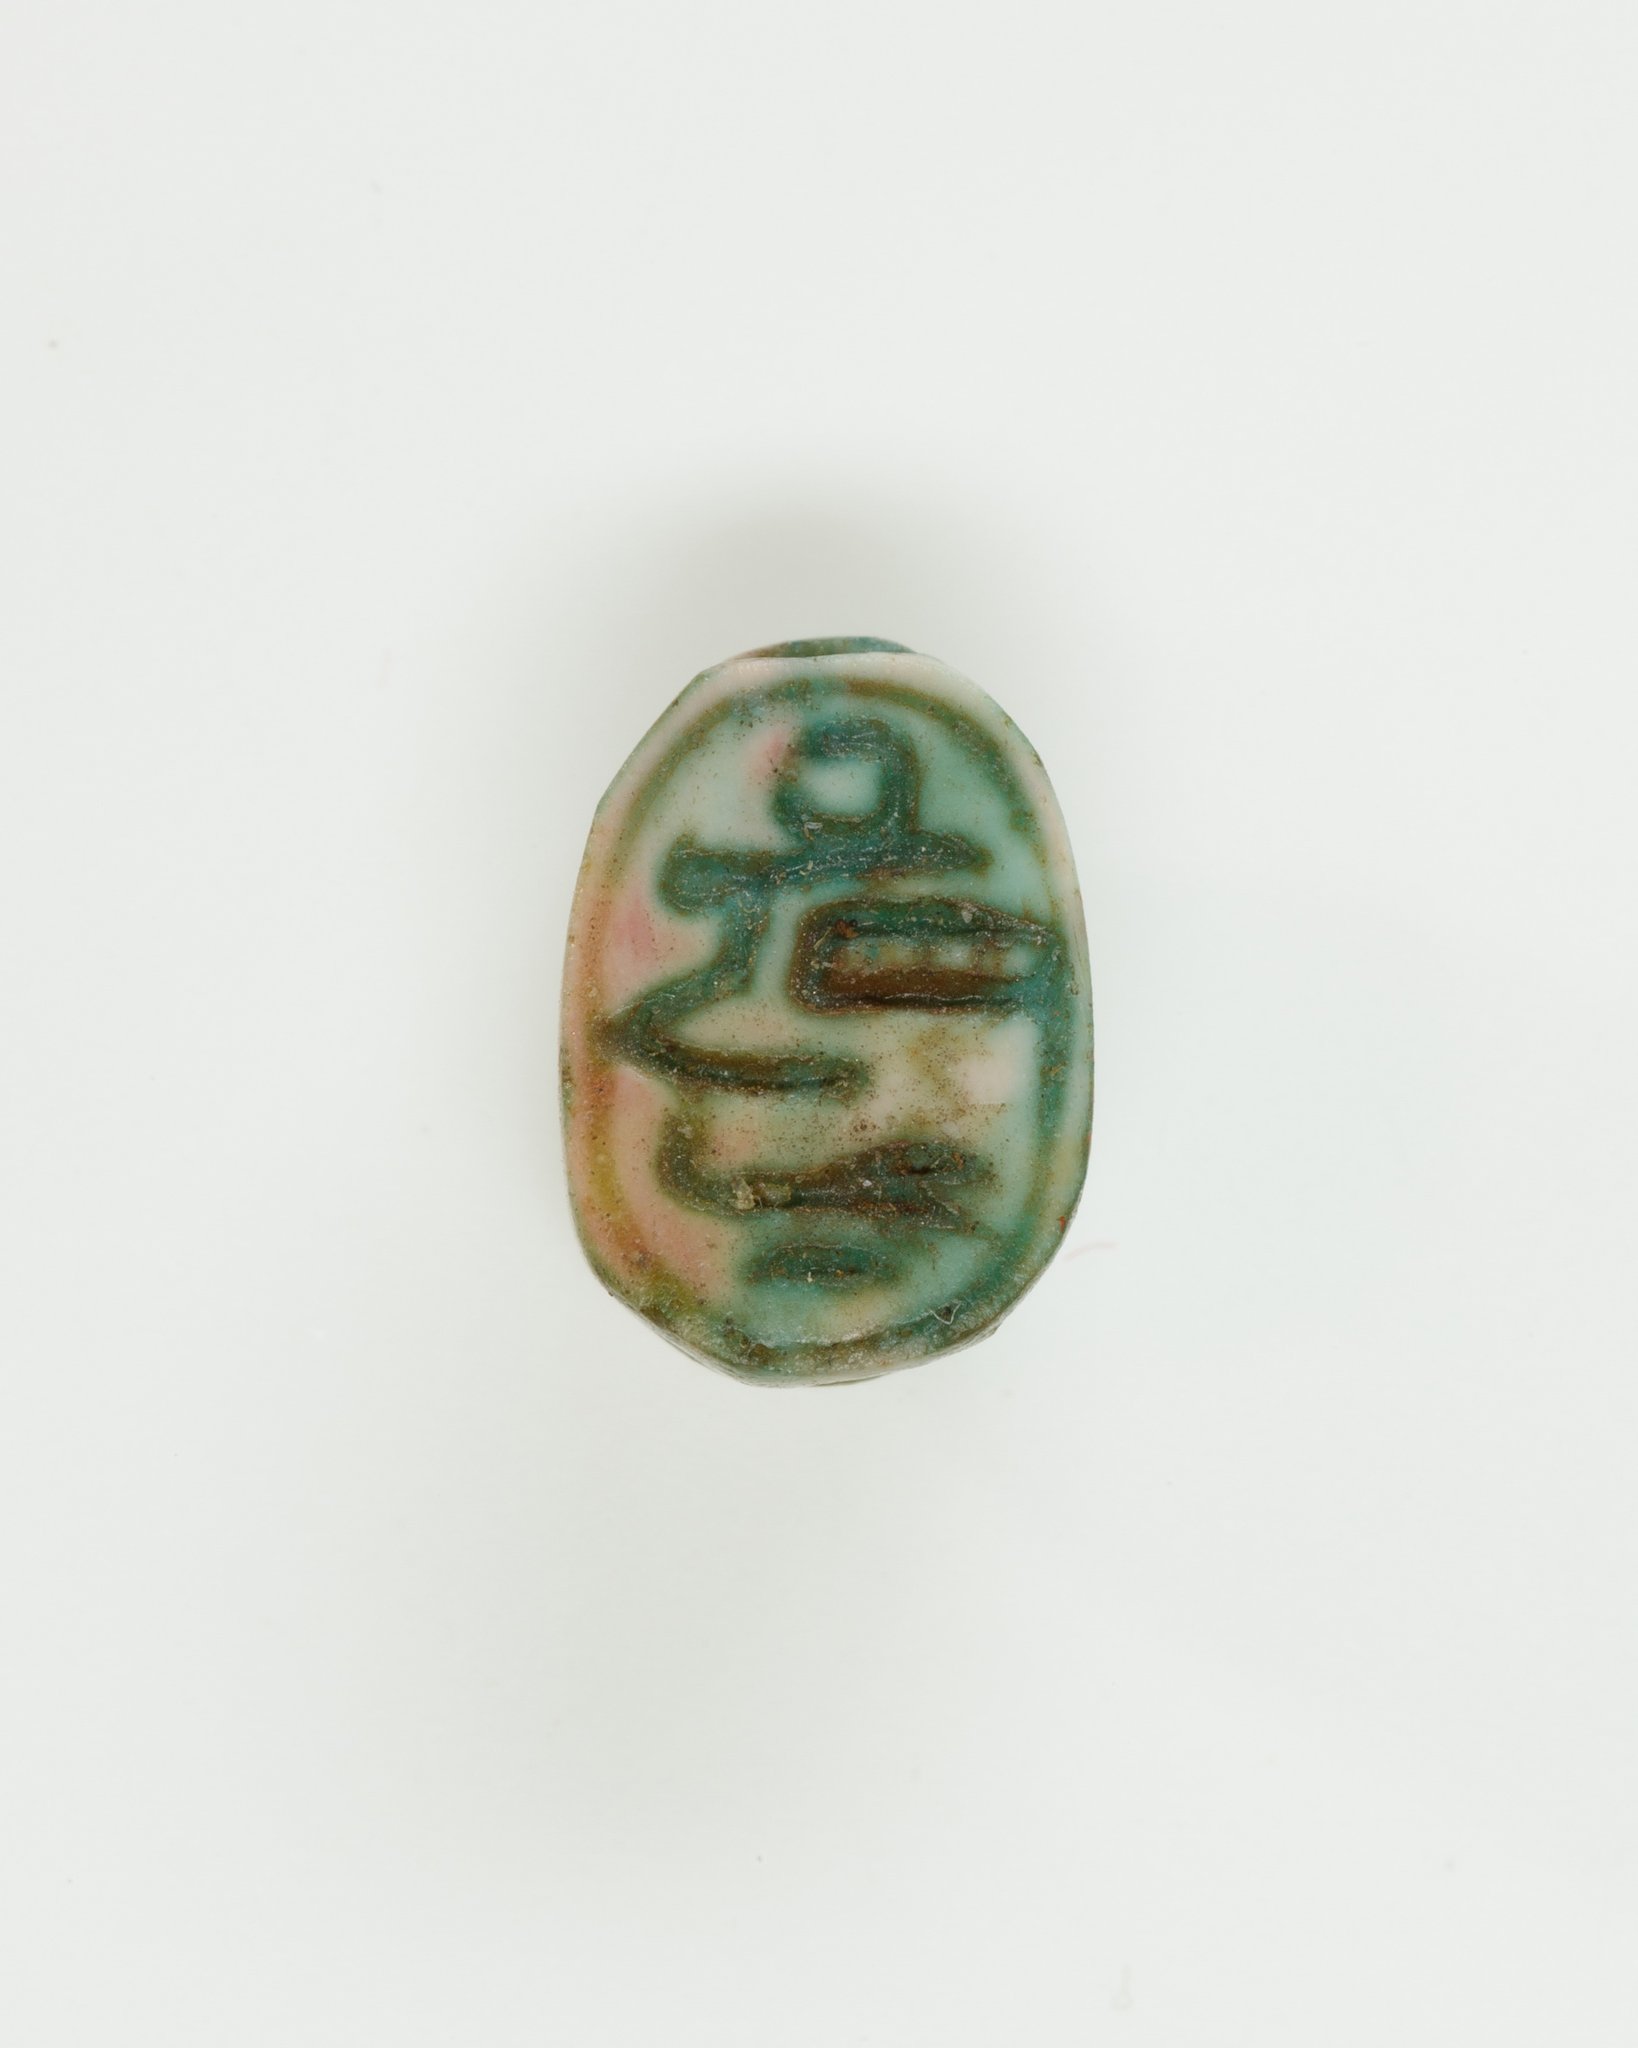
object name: scarab, amenemhat iii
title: Scarab of Amenemhat III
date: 1859-1813 BCE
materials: stone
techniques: glazing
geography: egypt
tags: hieroglyphs,scarabs